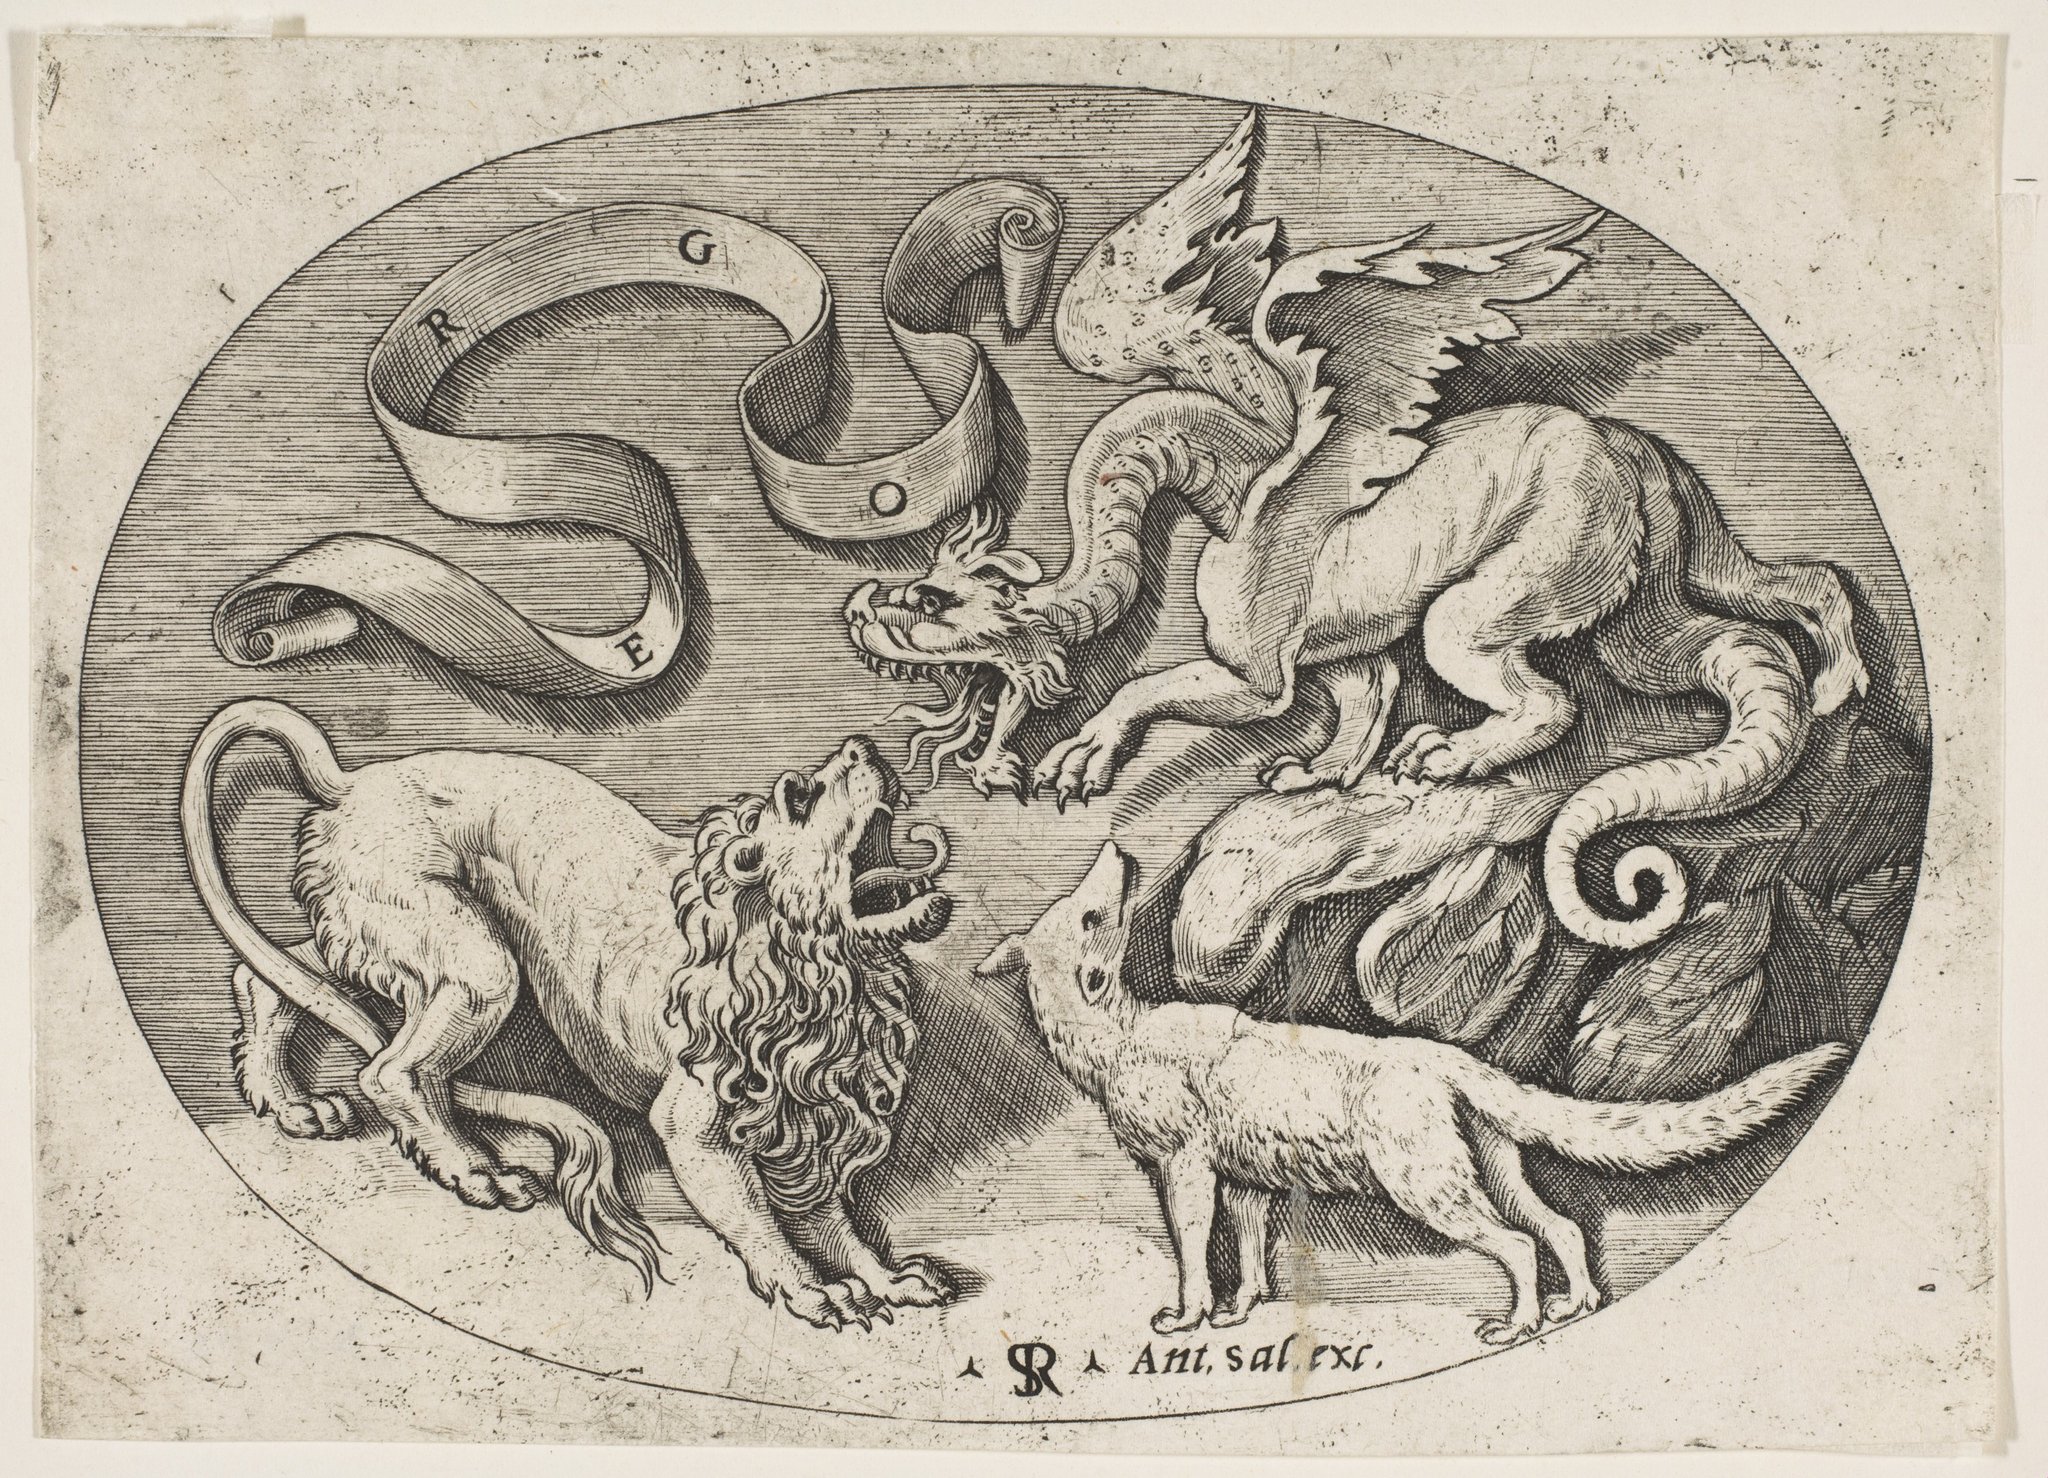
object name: print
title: A lion, dragon and fox fighting each other, an inscribed banderole above, an oval composition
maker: marco dente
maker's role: artist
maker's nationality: italian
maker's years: 1515-1527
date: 1515-1527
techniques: engraving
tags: dragons,foxes,lions,flags